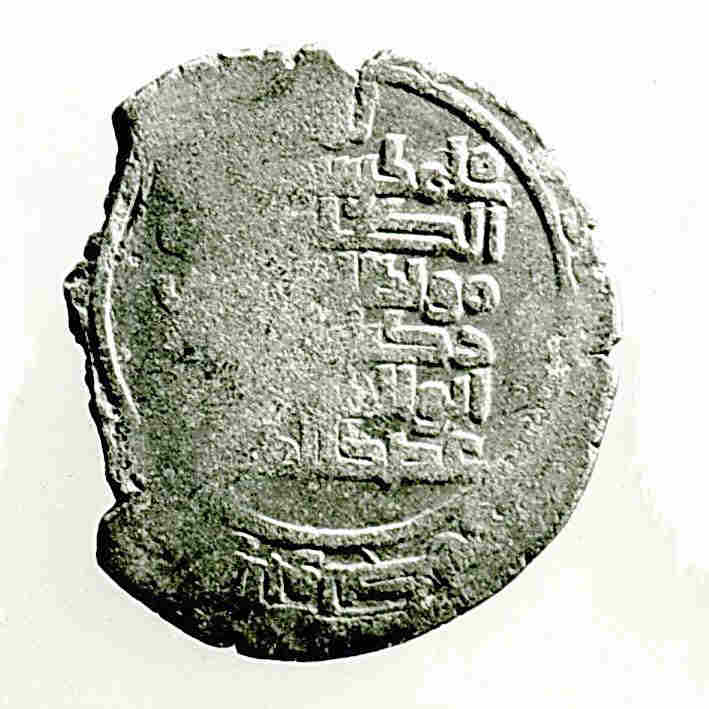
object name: coin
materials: silver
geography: iran